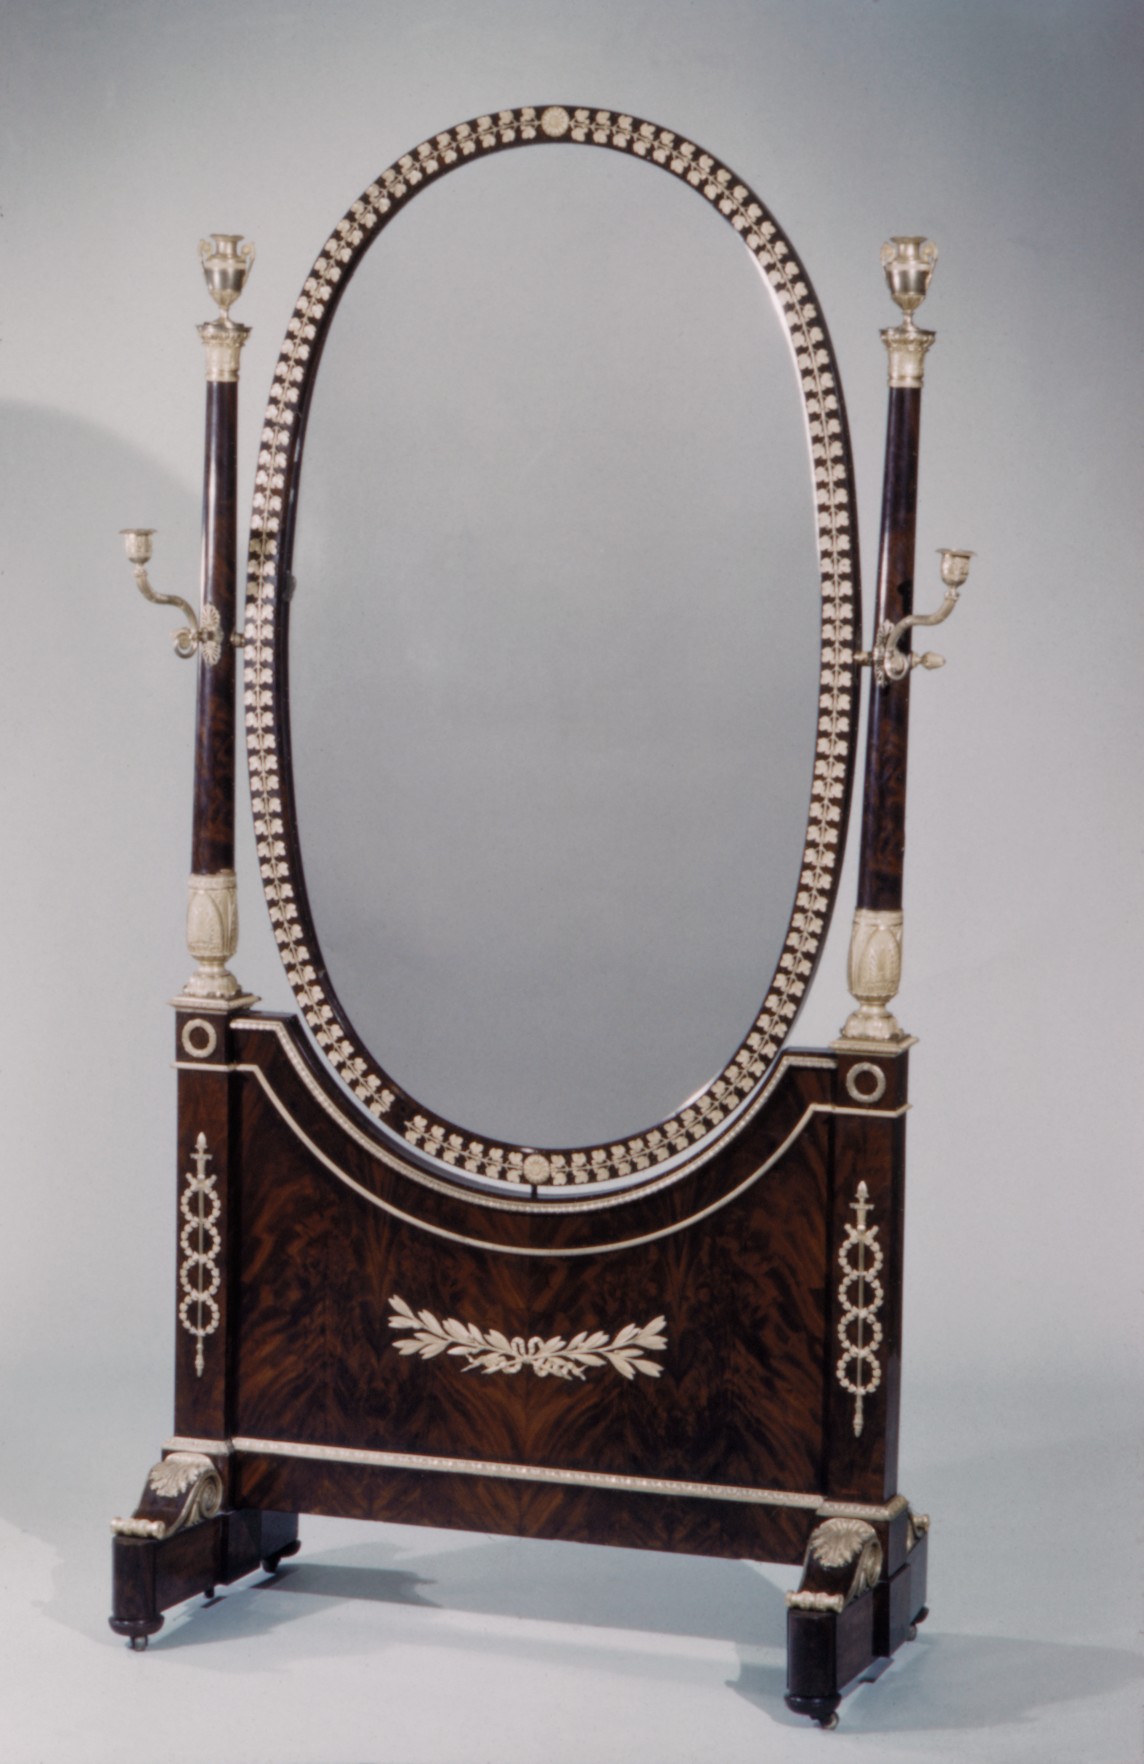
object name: cheval glass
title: Cheval glass (psyché)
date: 1801-1833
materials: gilt bronze, wood